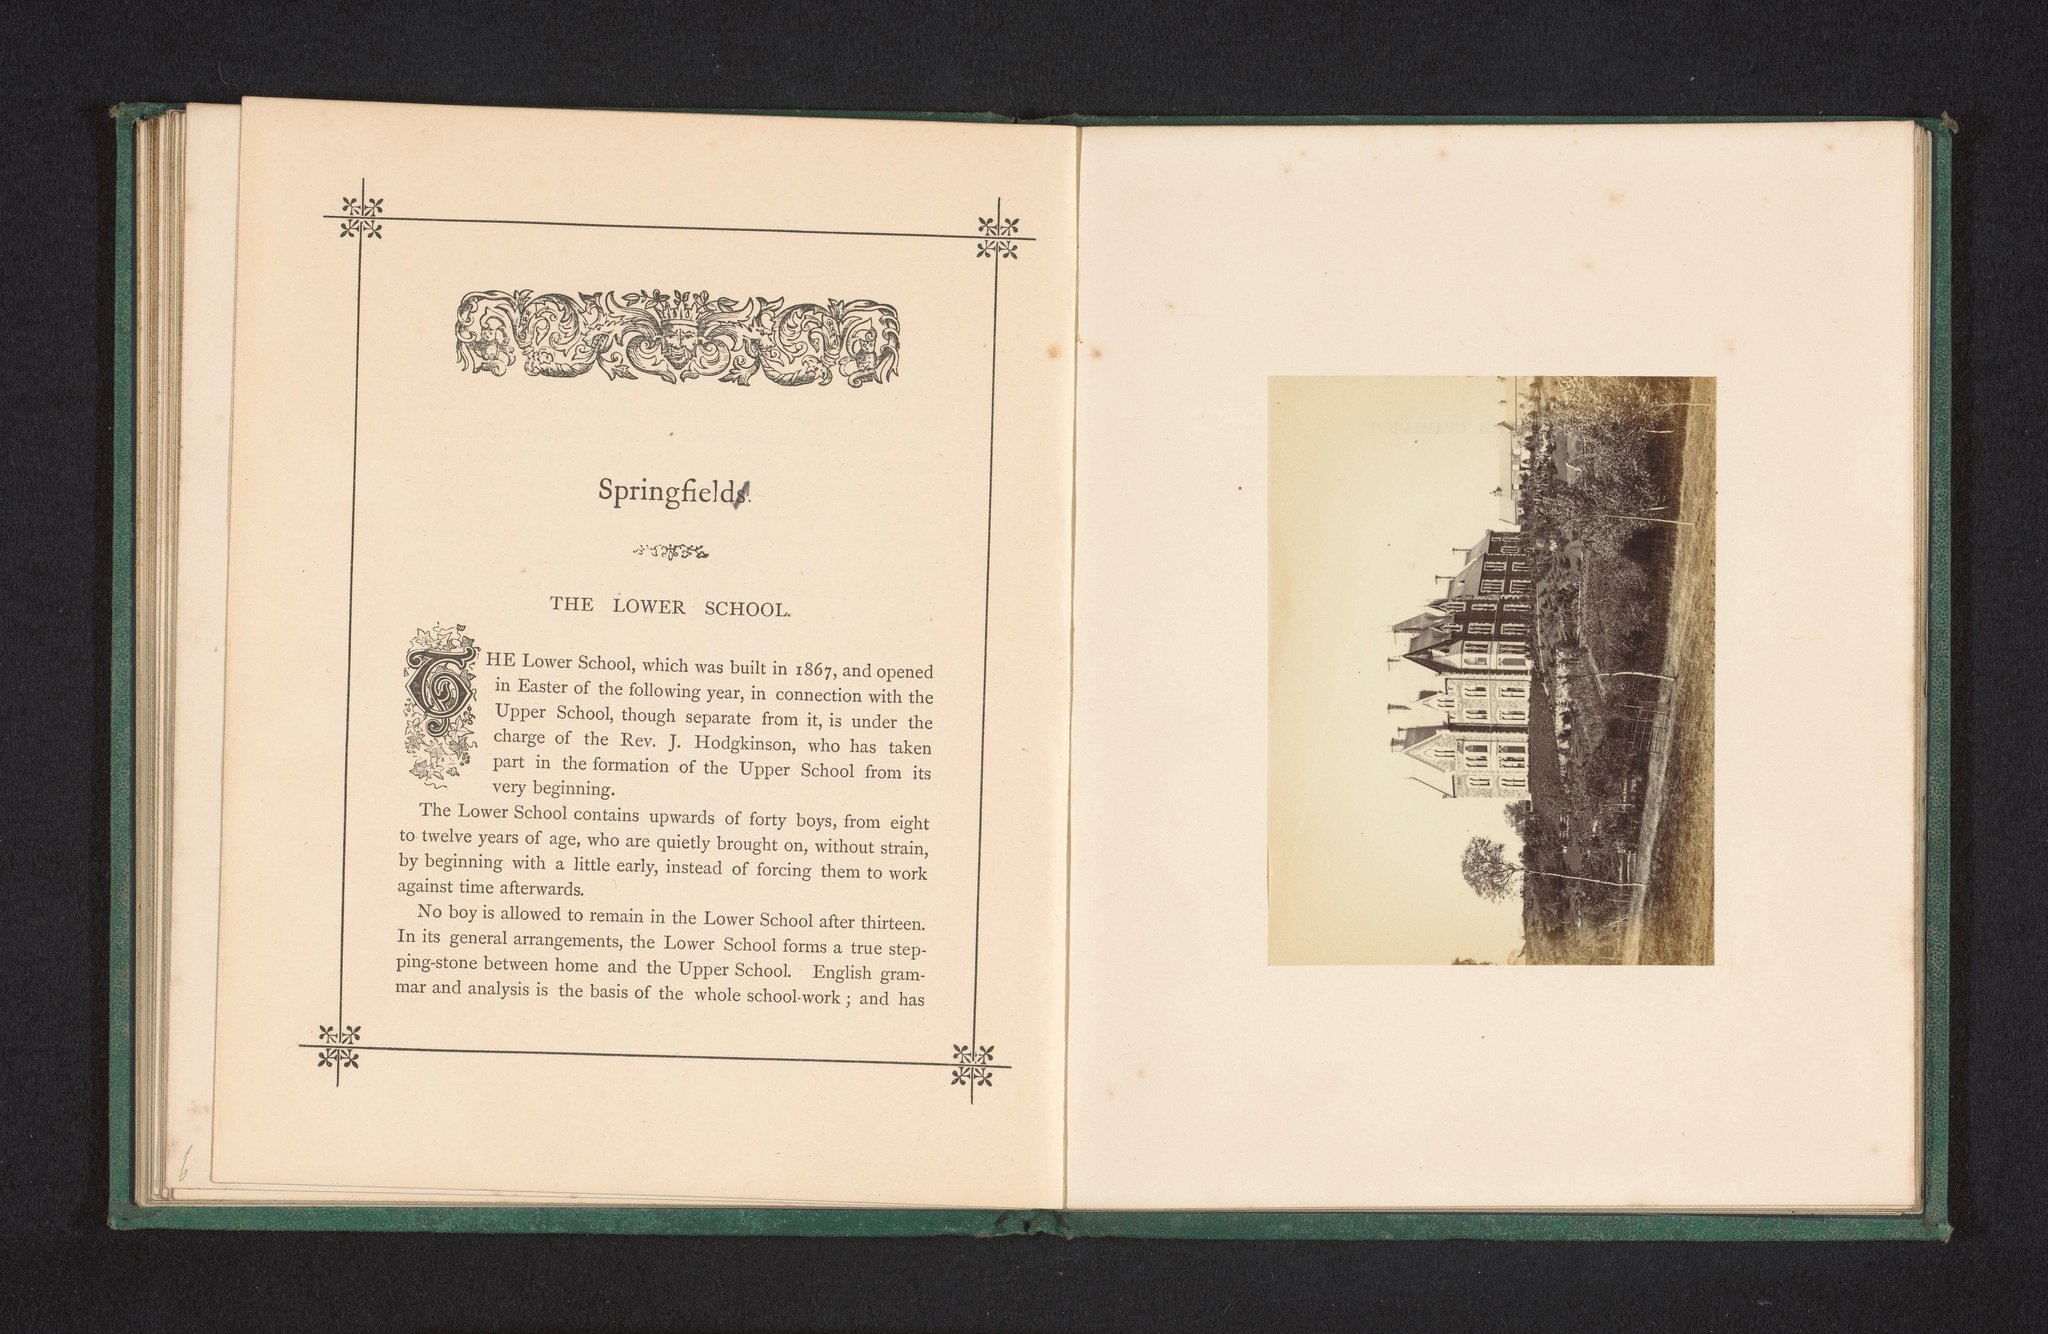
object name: photograph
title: Exterieur van het Springfield-gebouw van Uppingham School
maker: charles drake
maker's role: fotograaf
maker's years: 1846-1874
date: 1865-1870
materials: photographic support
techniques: albumen print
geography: uppingham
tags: façade (of house or building), elementary school; class, form